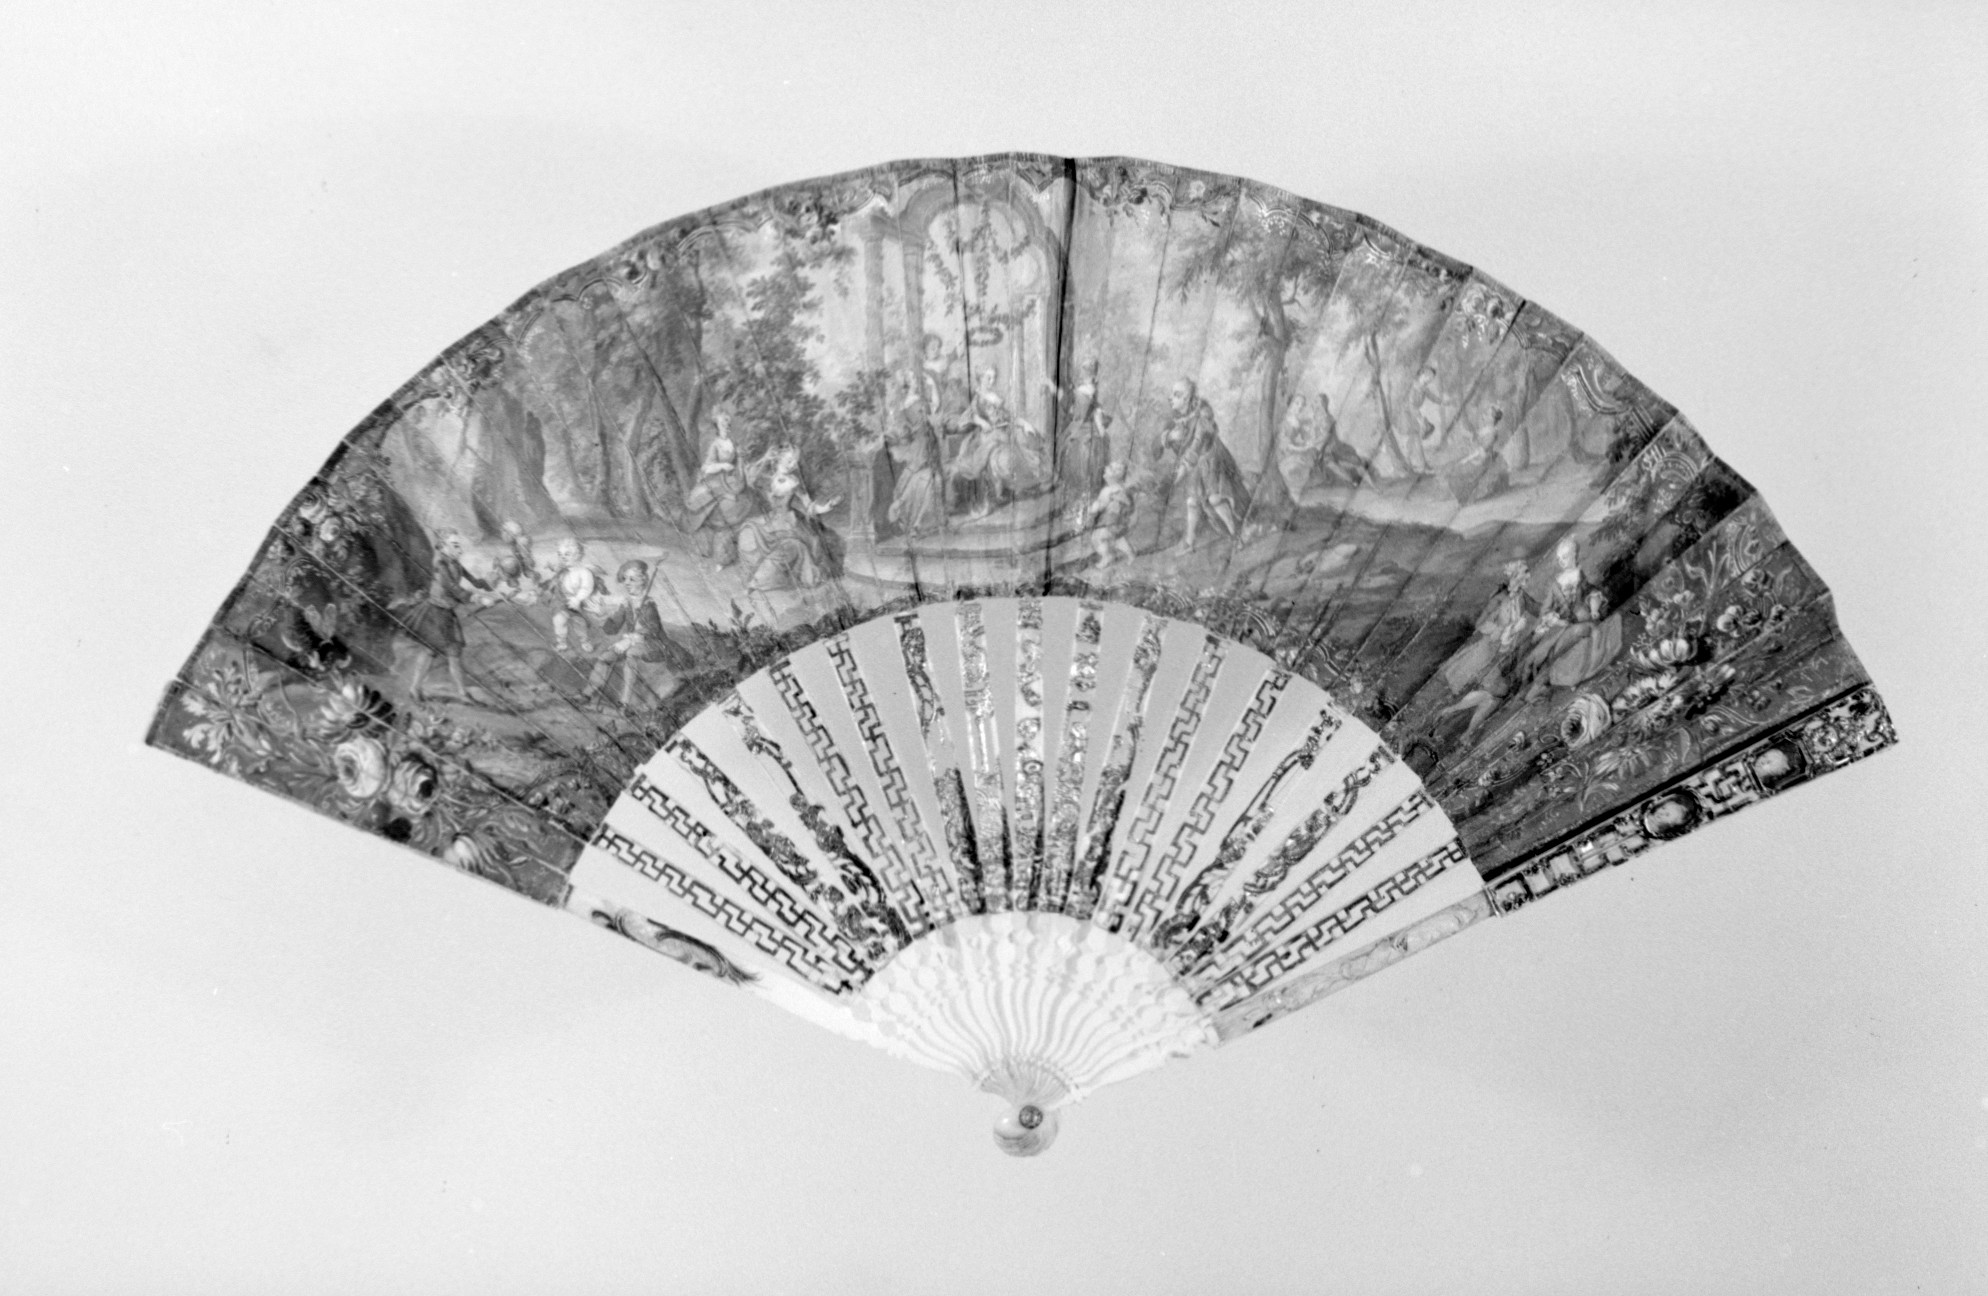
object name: fan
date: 1701-1800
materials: ivory, mother of pearl, paper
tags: children,men,women